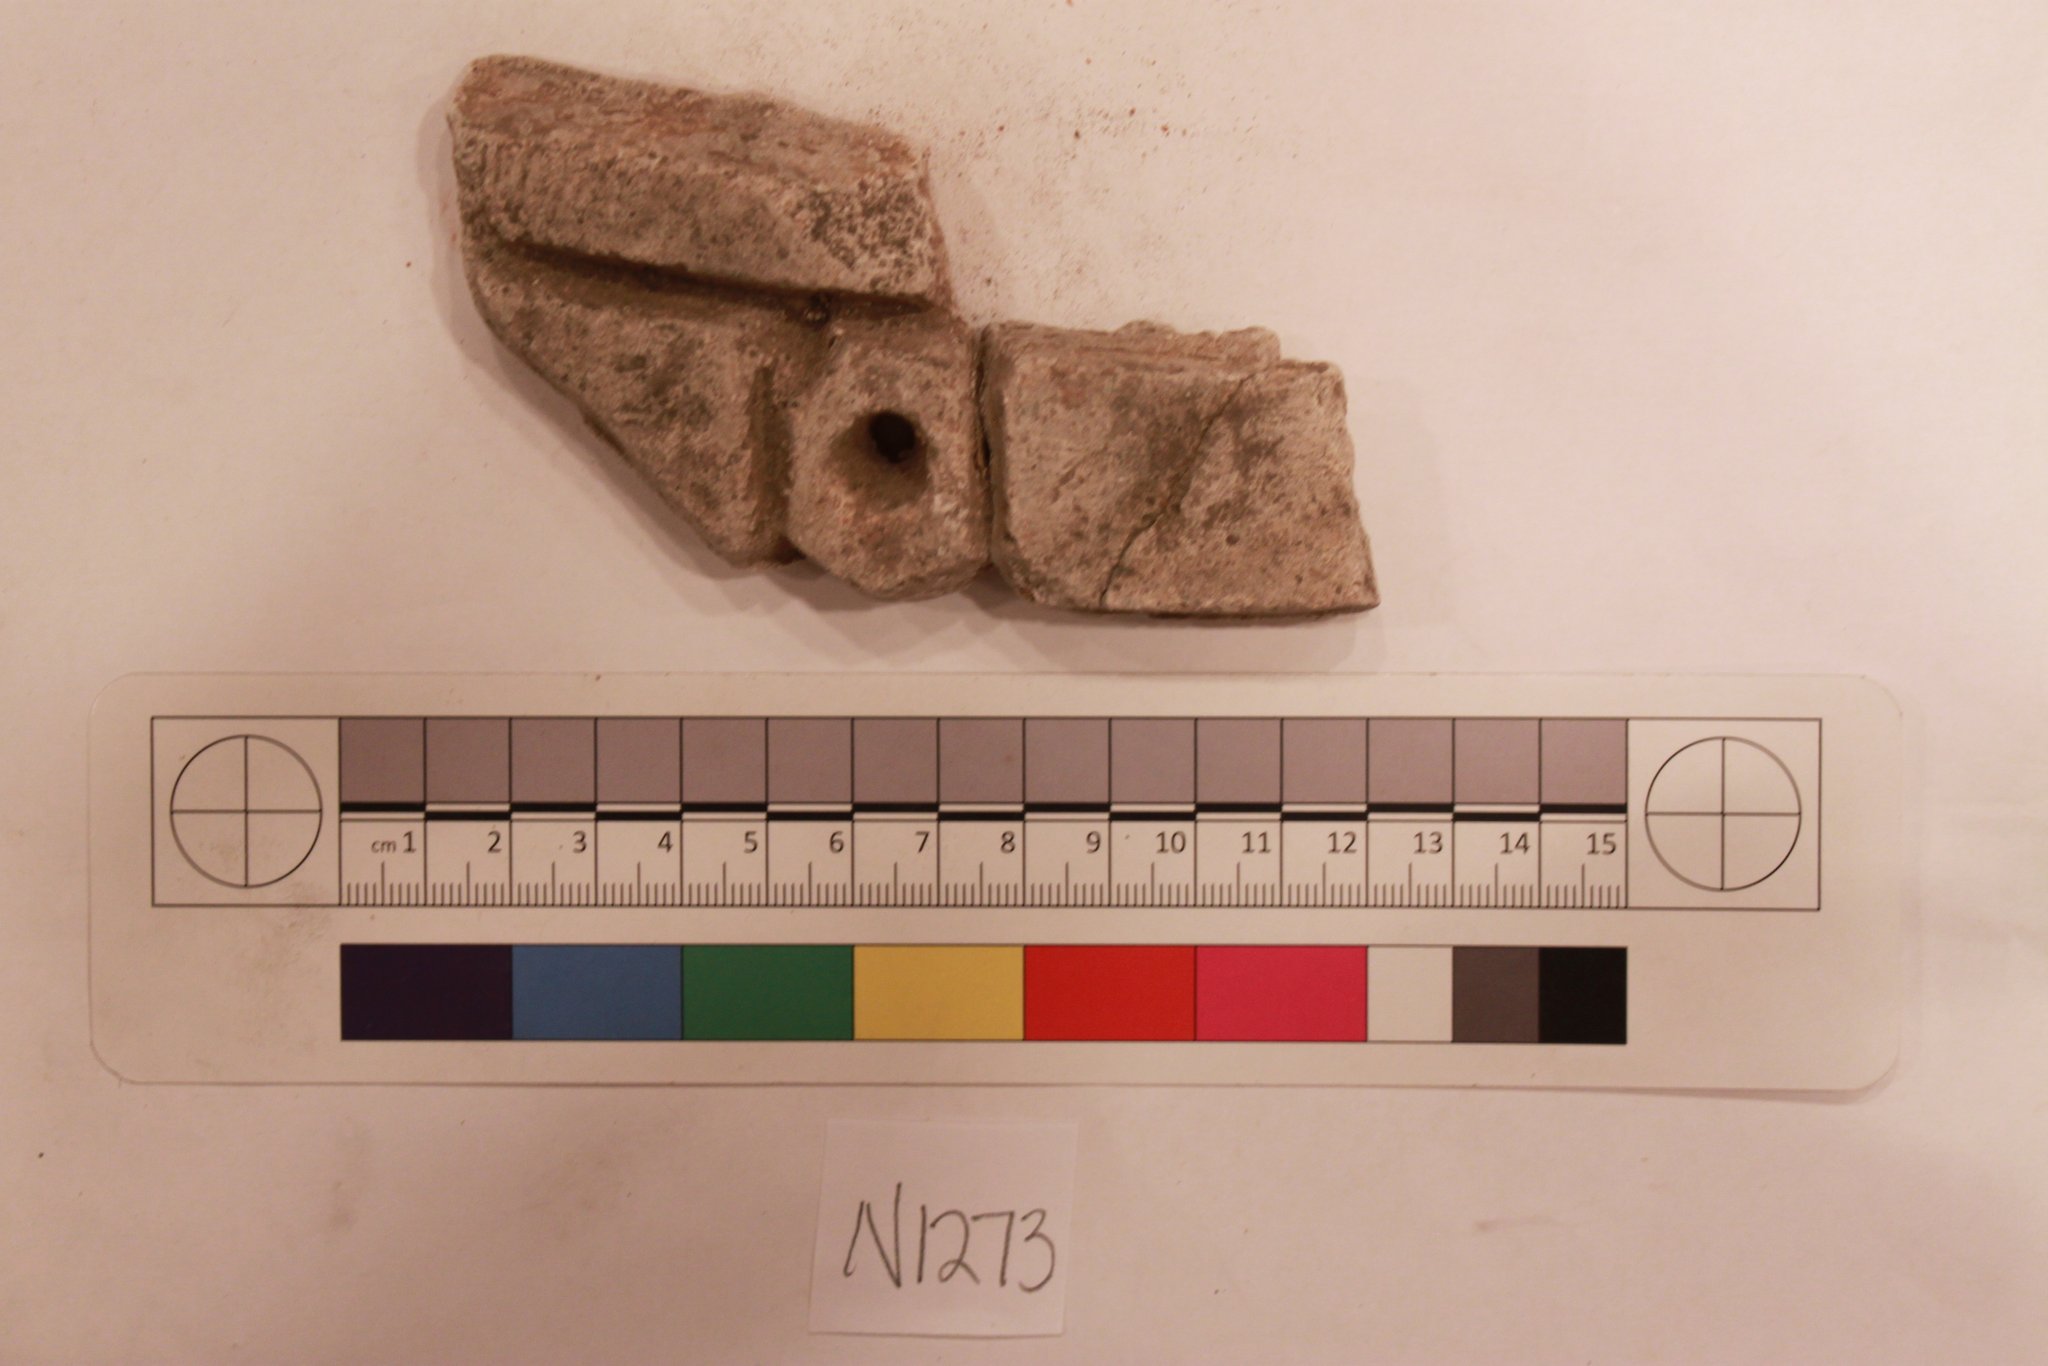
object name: fragment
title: Stucco Fragment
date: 701-1200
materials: plaster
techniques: carving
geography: iran